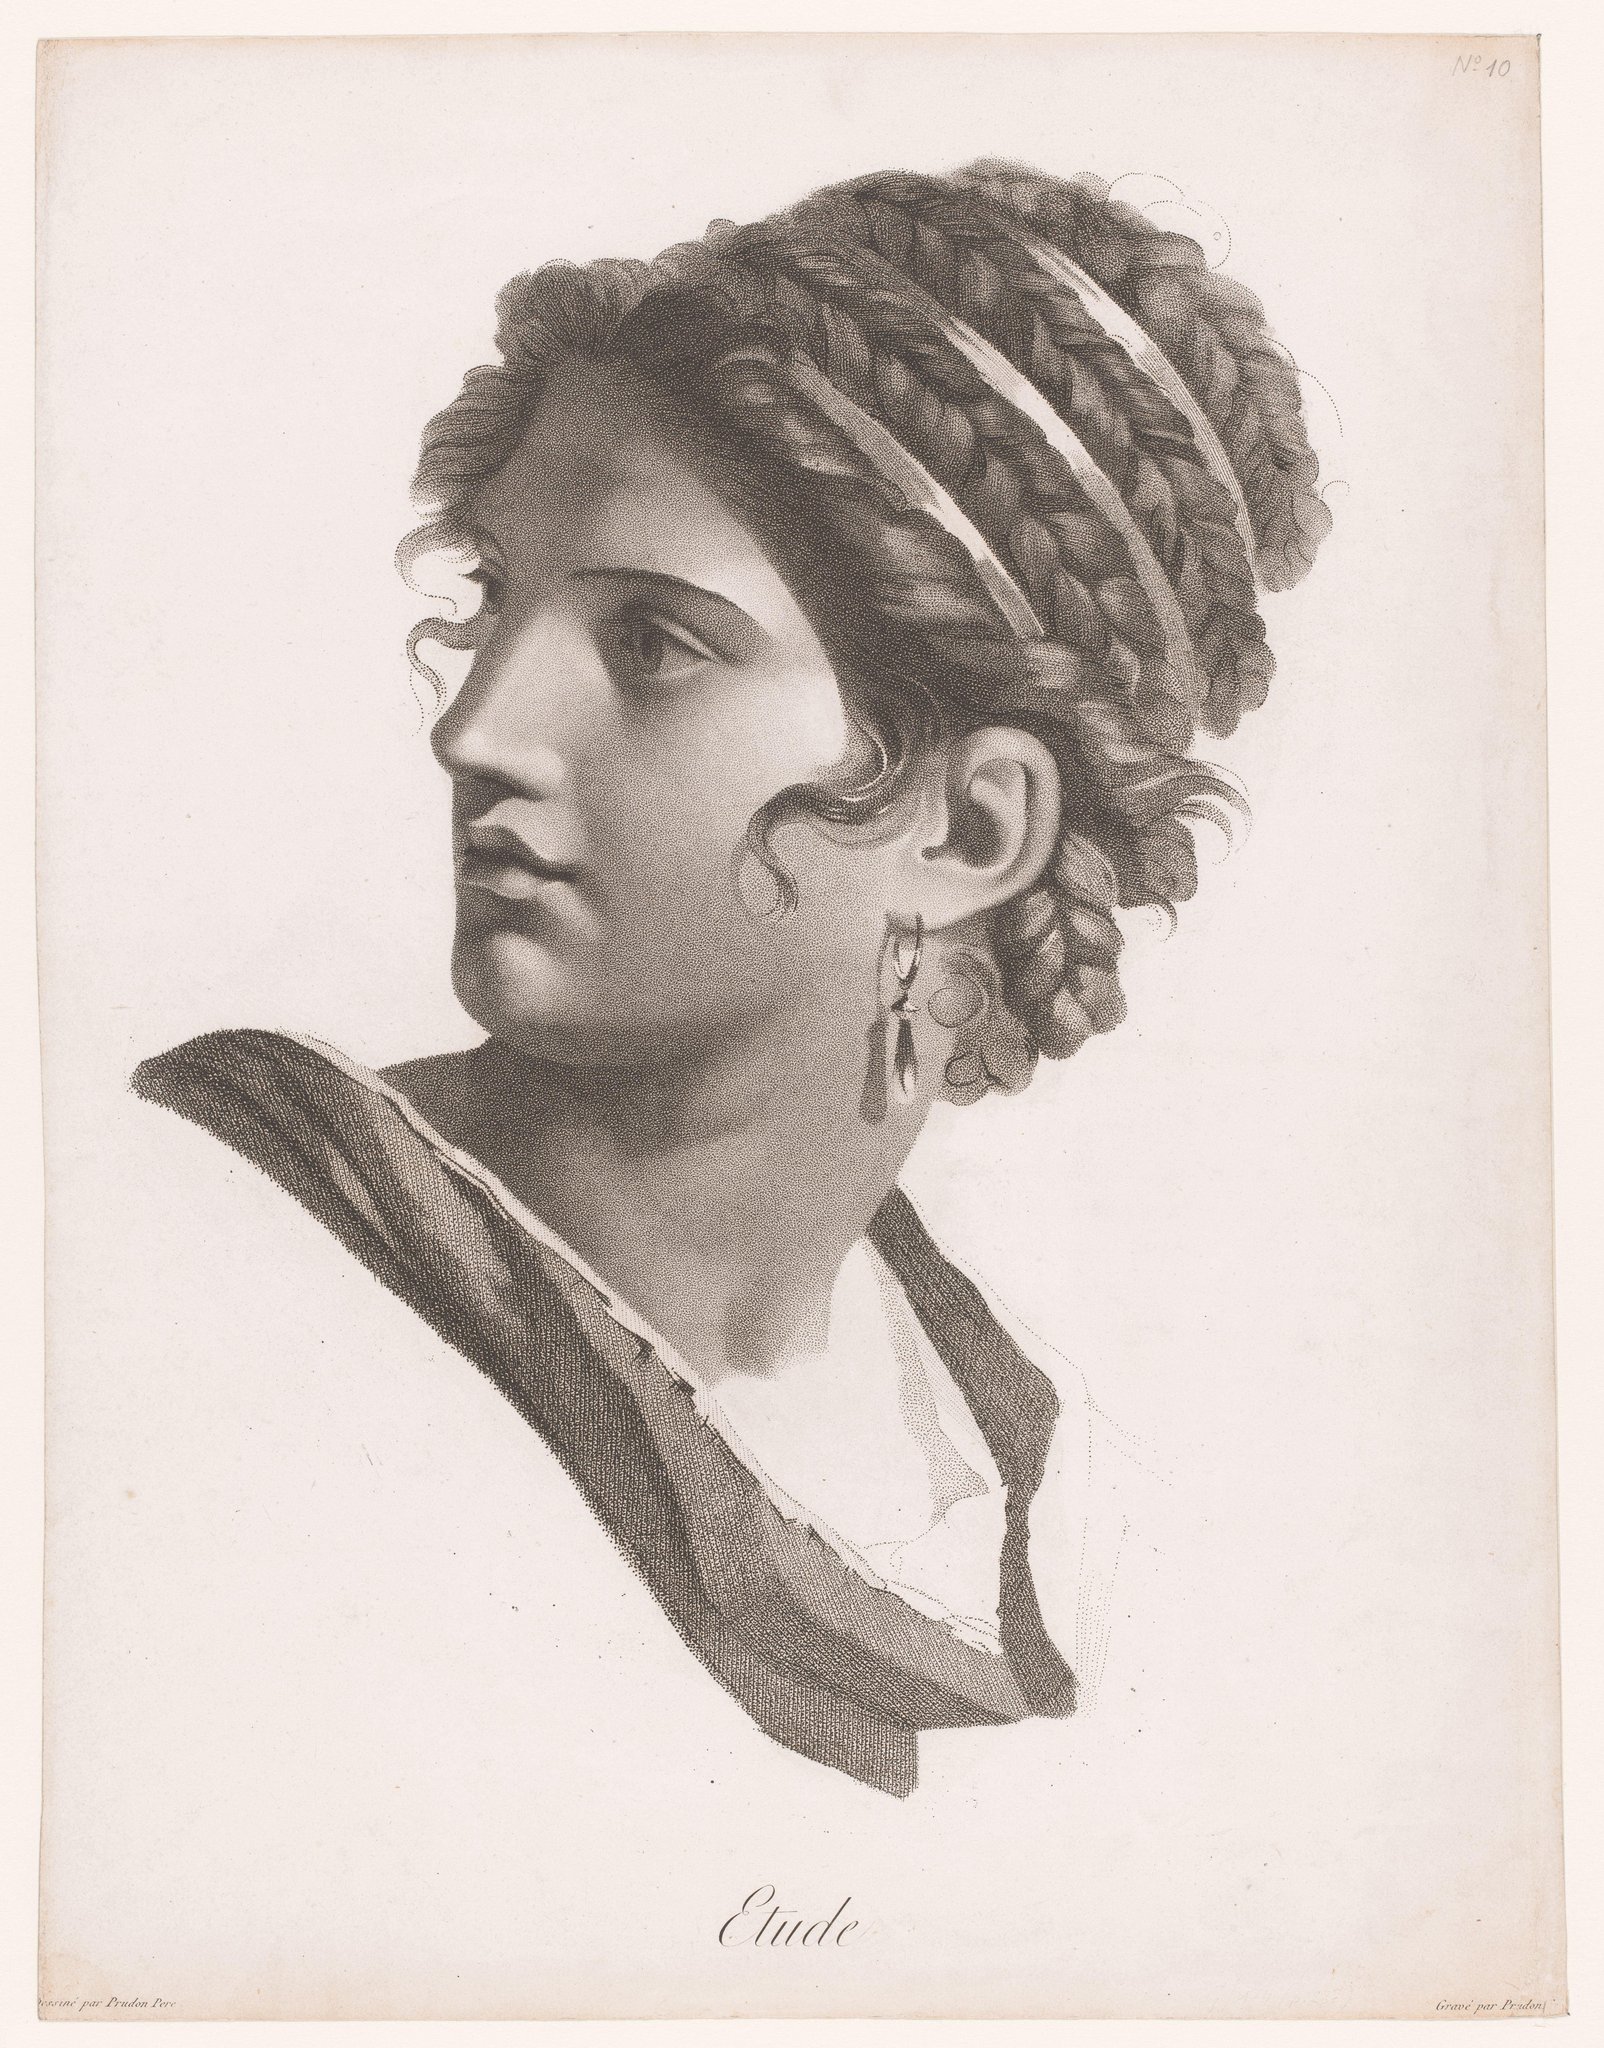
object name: print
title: Etude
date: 1800-1810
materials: paper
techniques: engraving, etching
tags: knowledge; 'cognitione', 'cognitione delle cose' (ripa), symbolic representations, allegories and emblems ~ education; 'ammaestramento', dottrina', 'educatione', 'istitutione' (ripa)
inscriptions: collector's mark: Lugt 2228